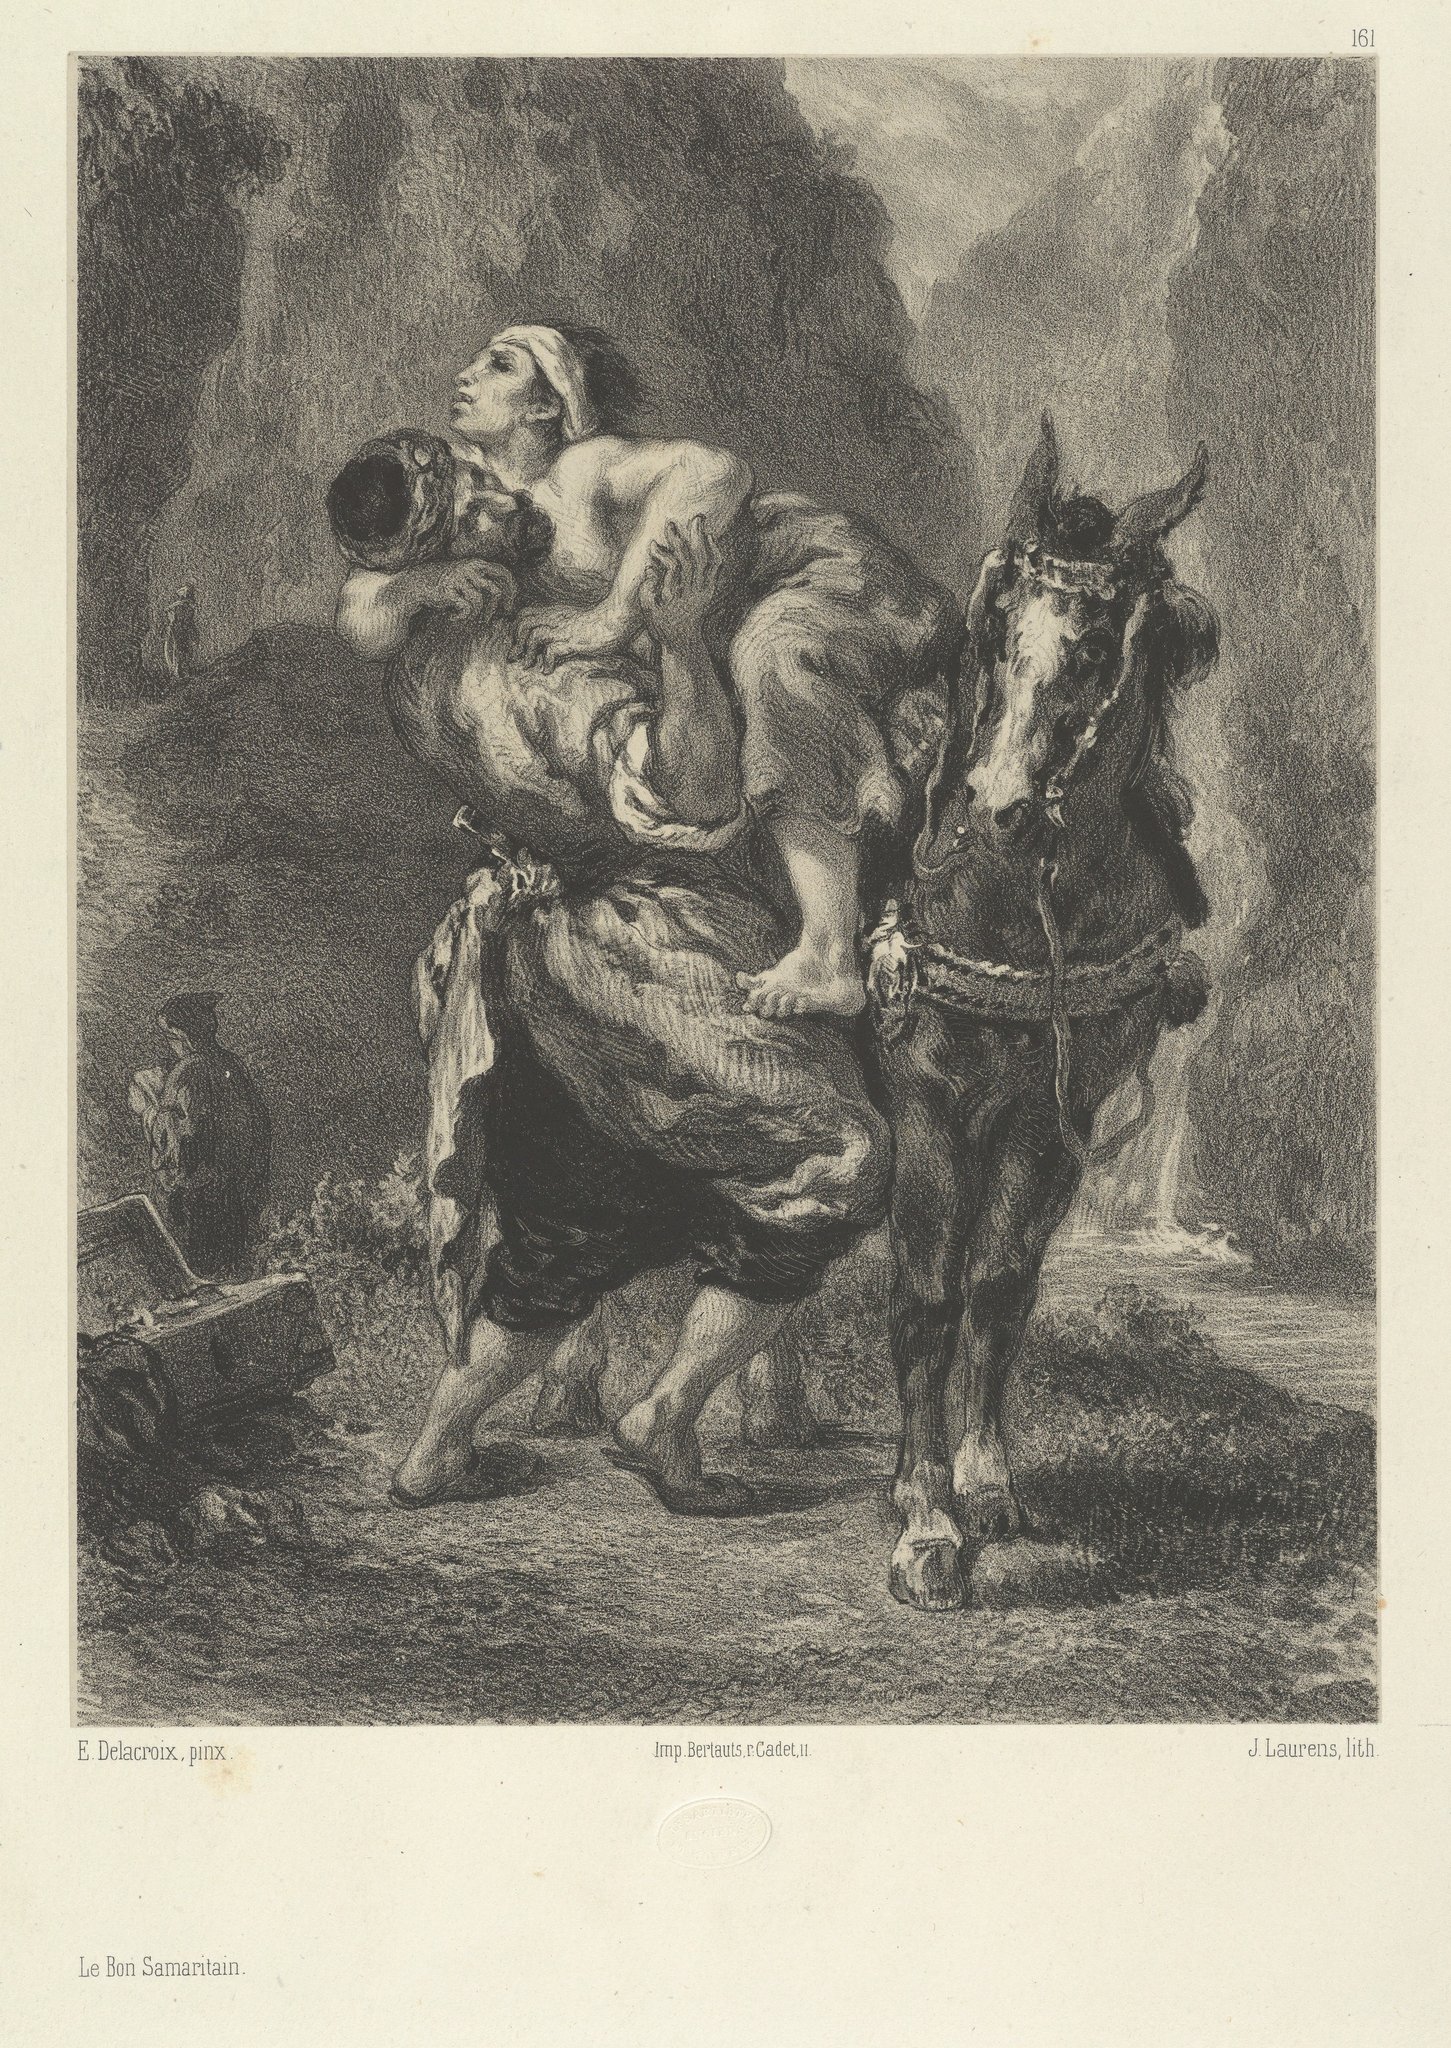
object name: print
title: The Good Samaritan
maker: jules laurens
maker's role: artist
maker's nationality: french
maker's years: 1825-1901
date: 1857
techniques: printmaking, lithograph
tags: men,women,horses